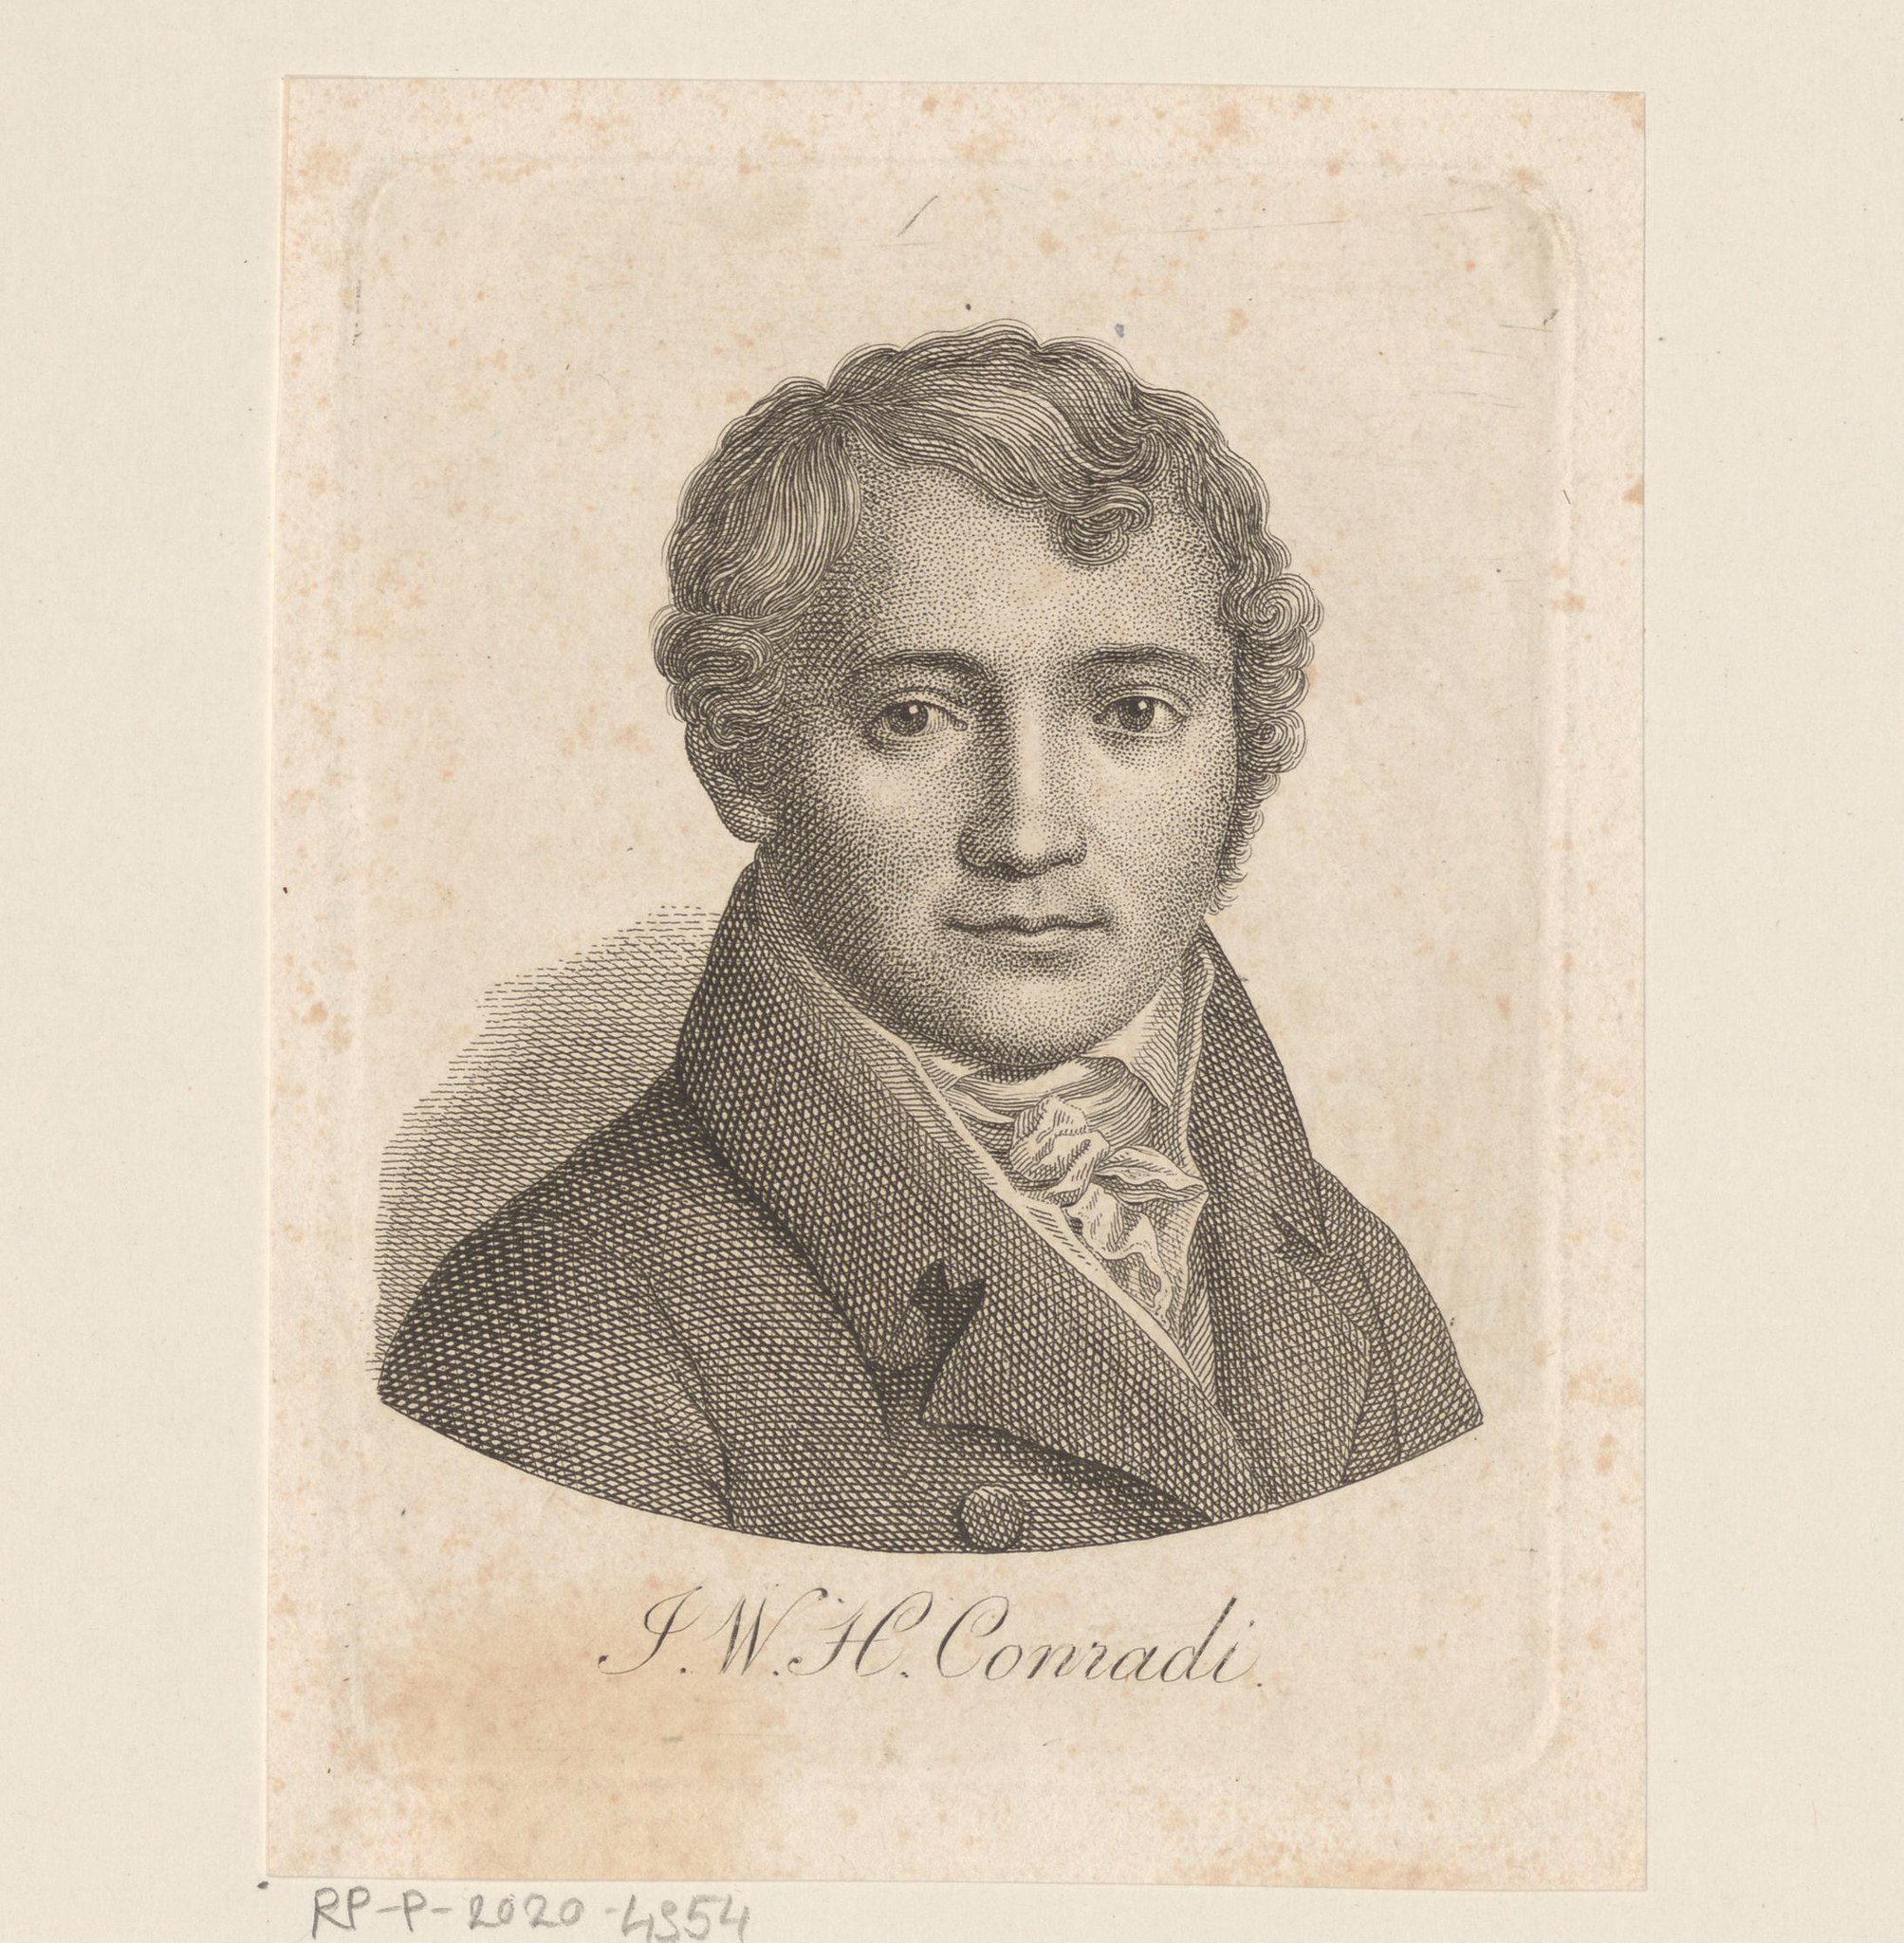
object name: print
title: Portret van Johann Wilhelm Heinrich Conradi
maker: Anonymous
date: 1800-1899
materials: paper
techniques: etching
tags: historical persons